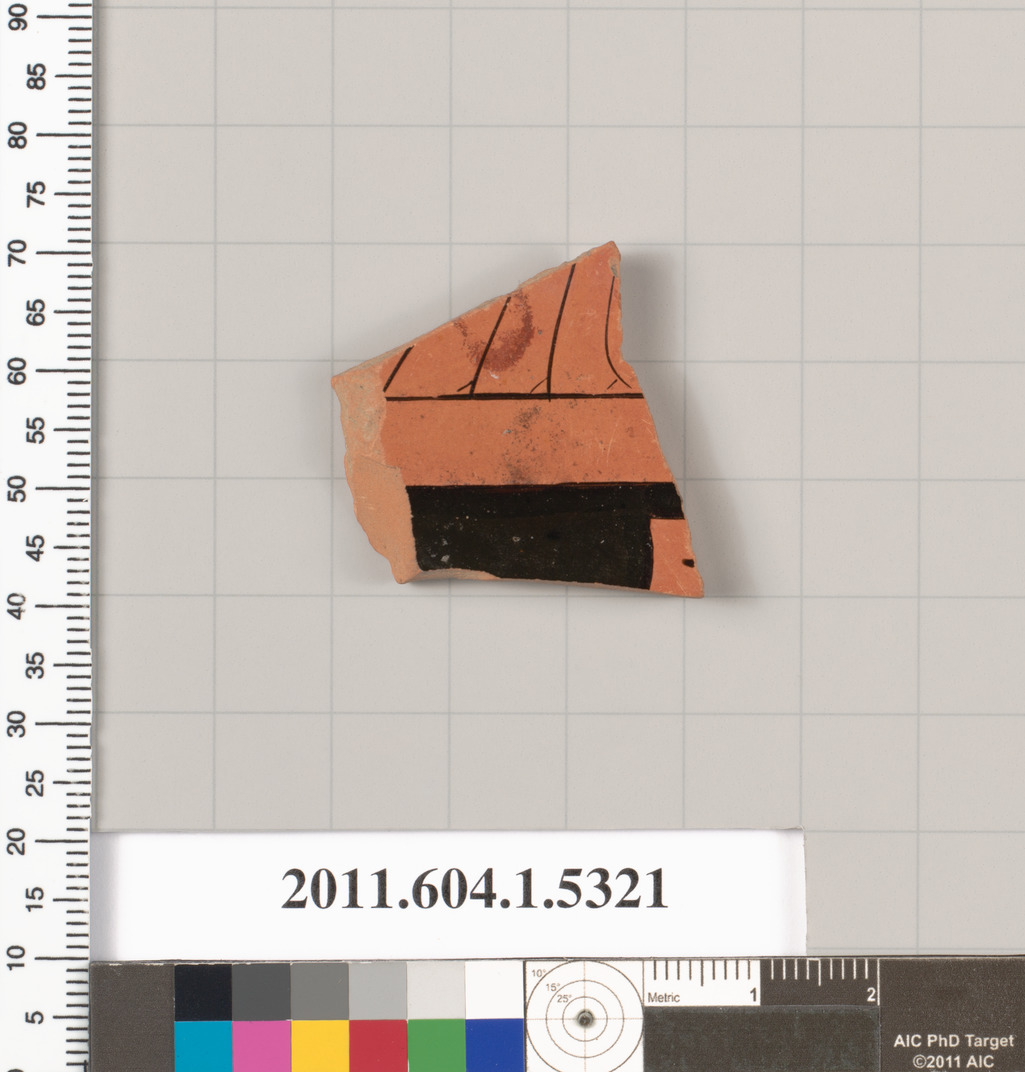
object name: kylix fragment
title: Terracotta fragment of a kylix (drinking cup)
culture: greek, attic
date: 500-480 BCE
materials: terracotta